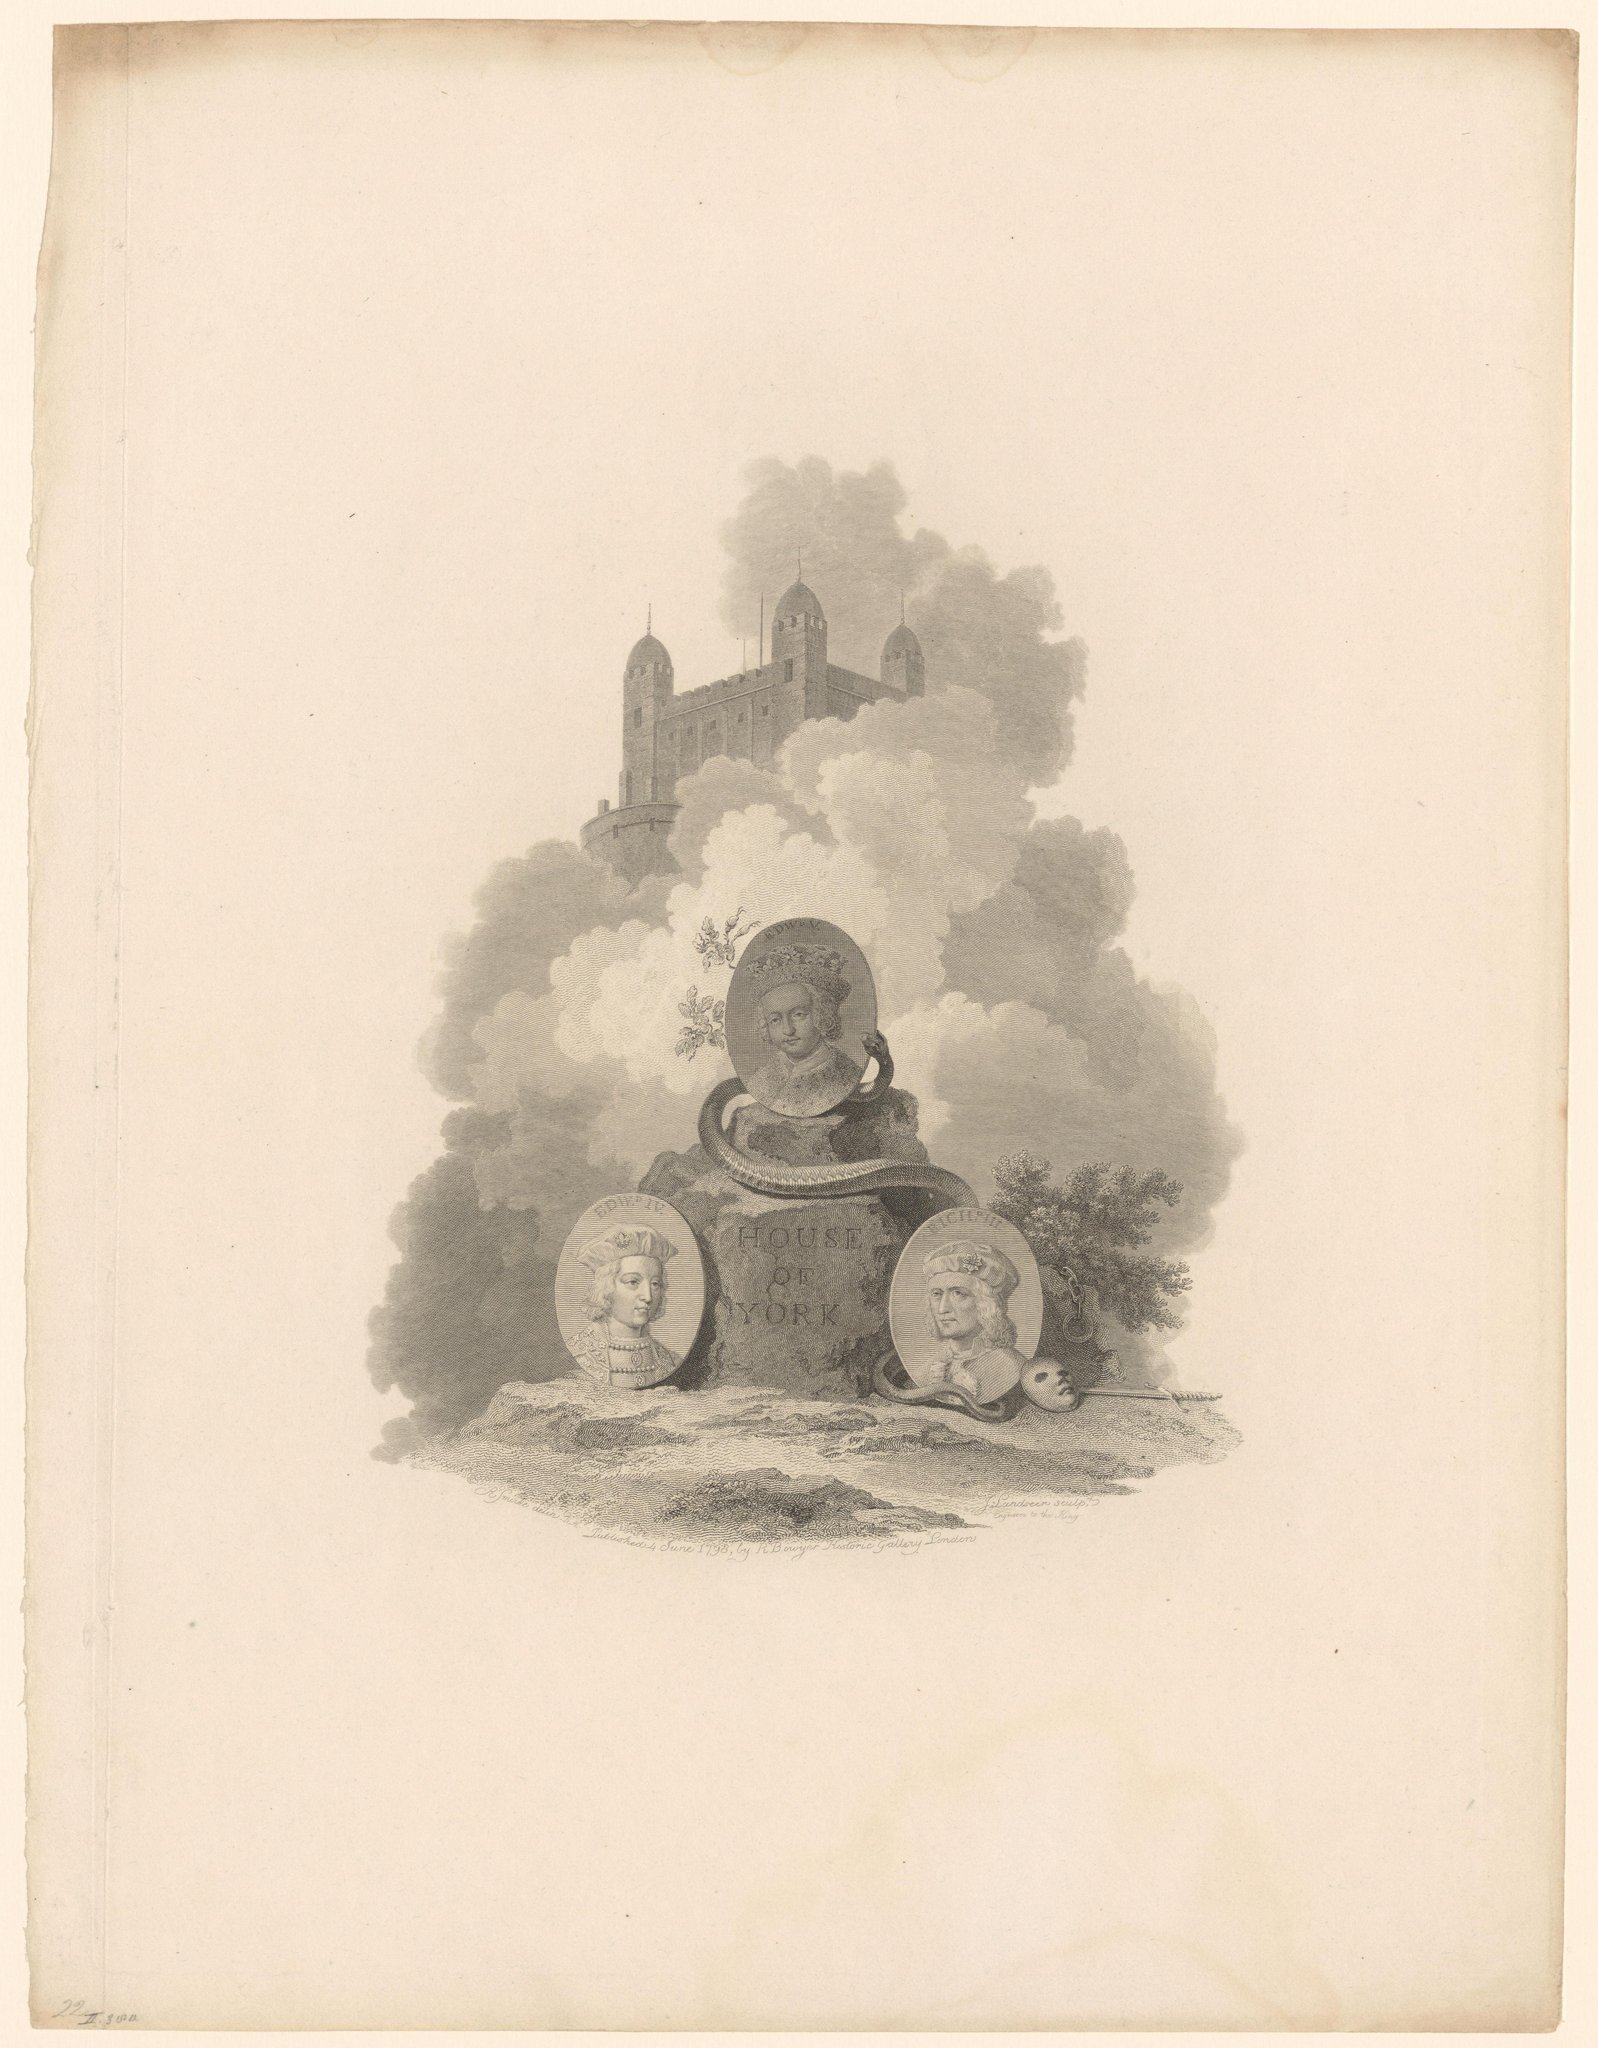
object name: print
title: Steen met portretten van Eduard IV, Eduard V en Eduard VI van het huis York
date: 1798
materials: paper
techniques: etching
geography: london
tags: westminster abbey, london, edward v, fortress, historical persons, king, armorial bearing, heraldry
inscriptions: collector's mark: Lugt 2228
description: Een slang wikkelt zich om de steen. In de wolken is een fort zichtbaar.